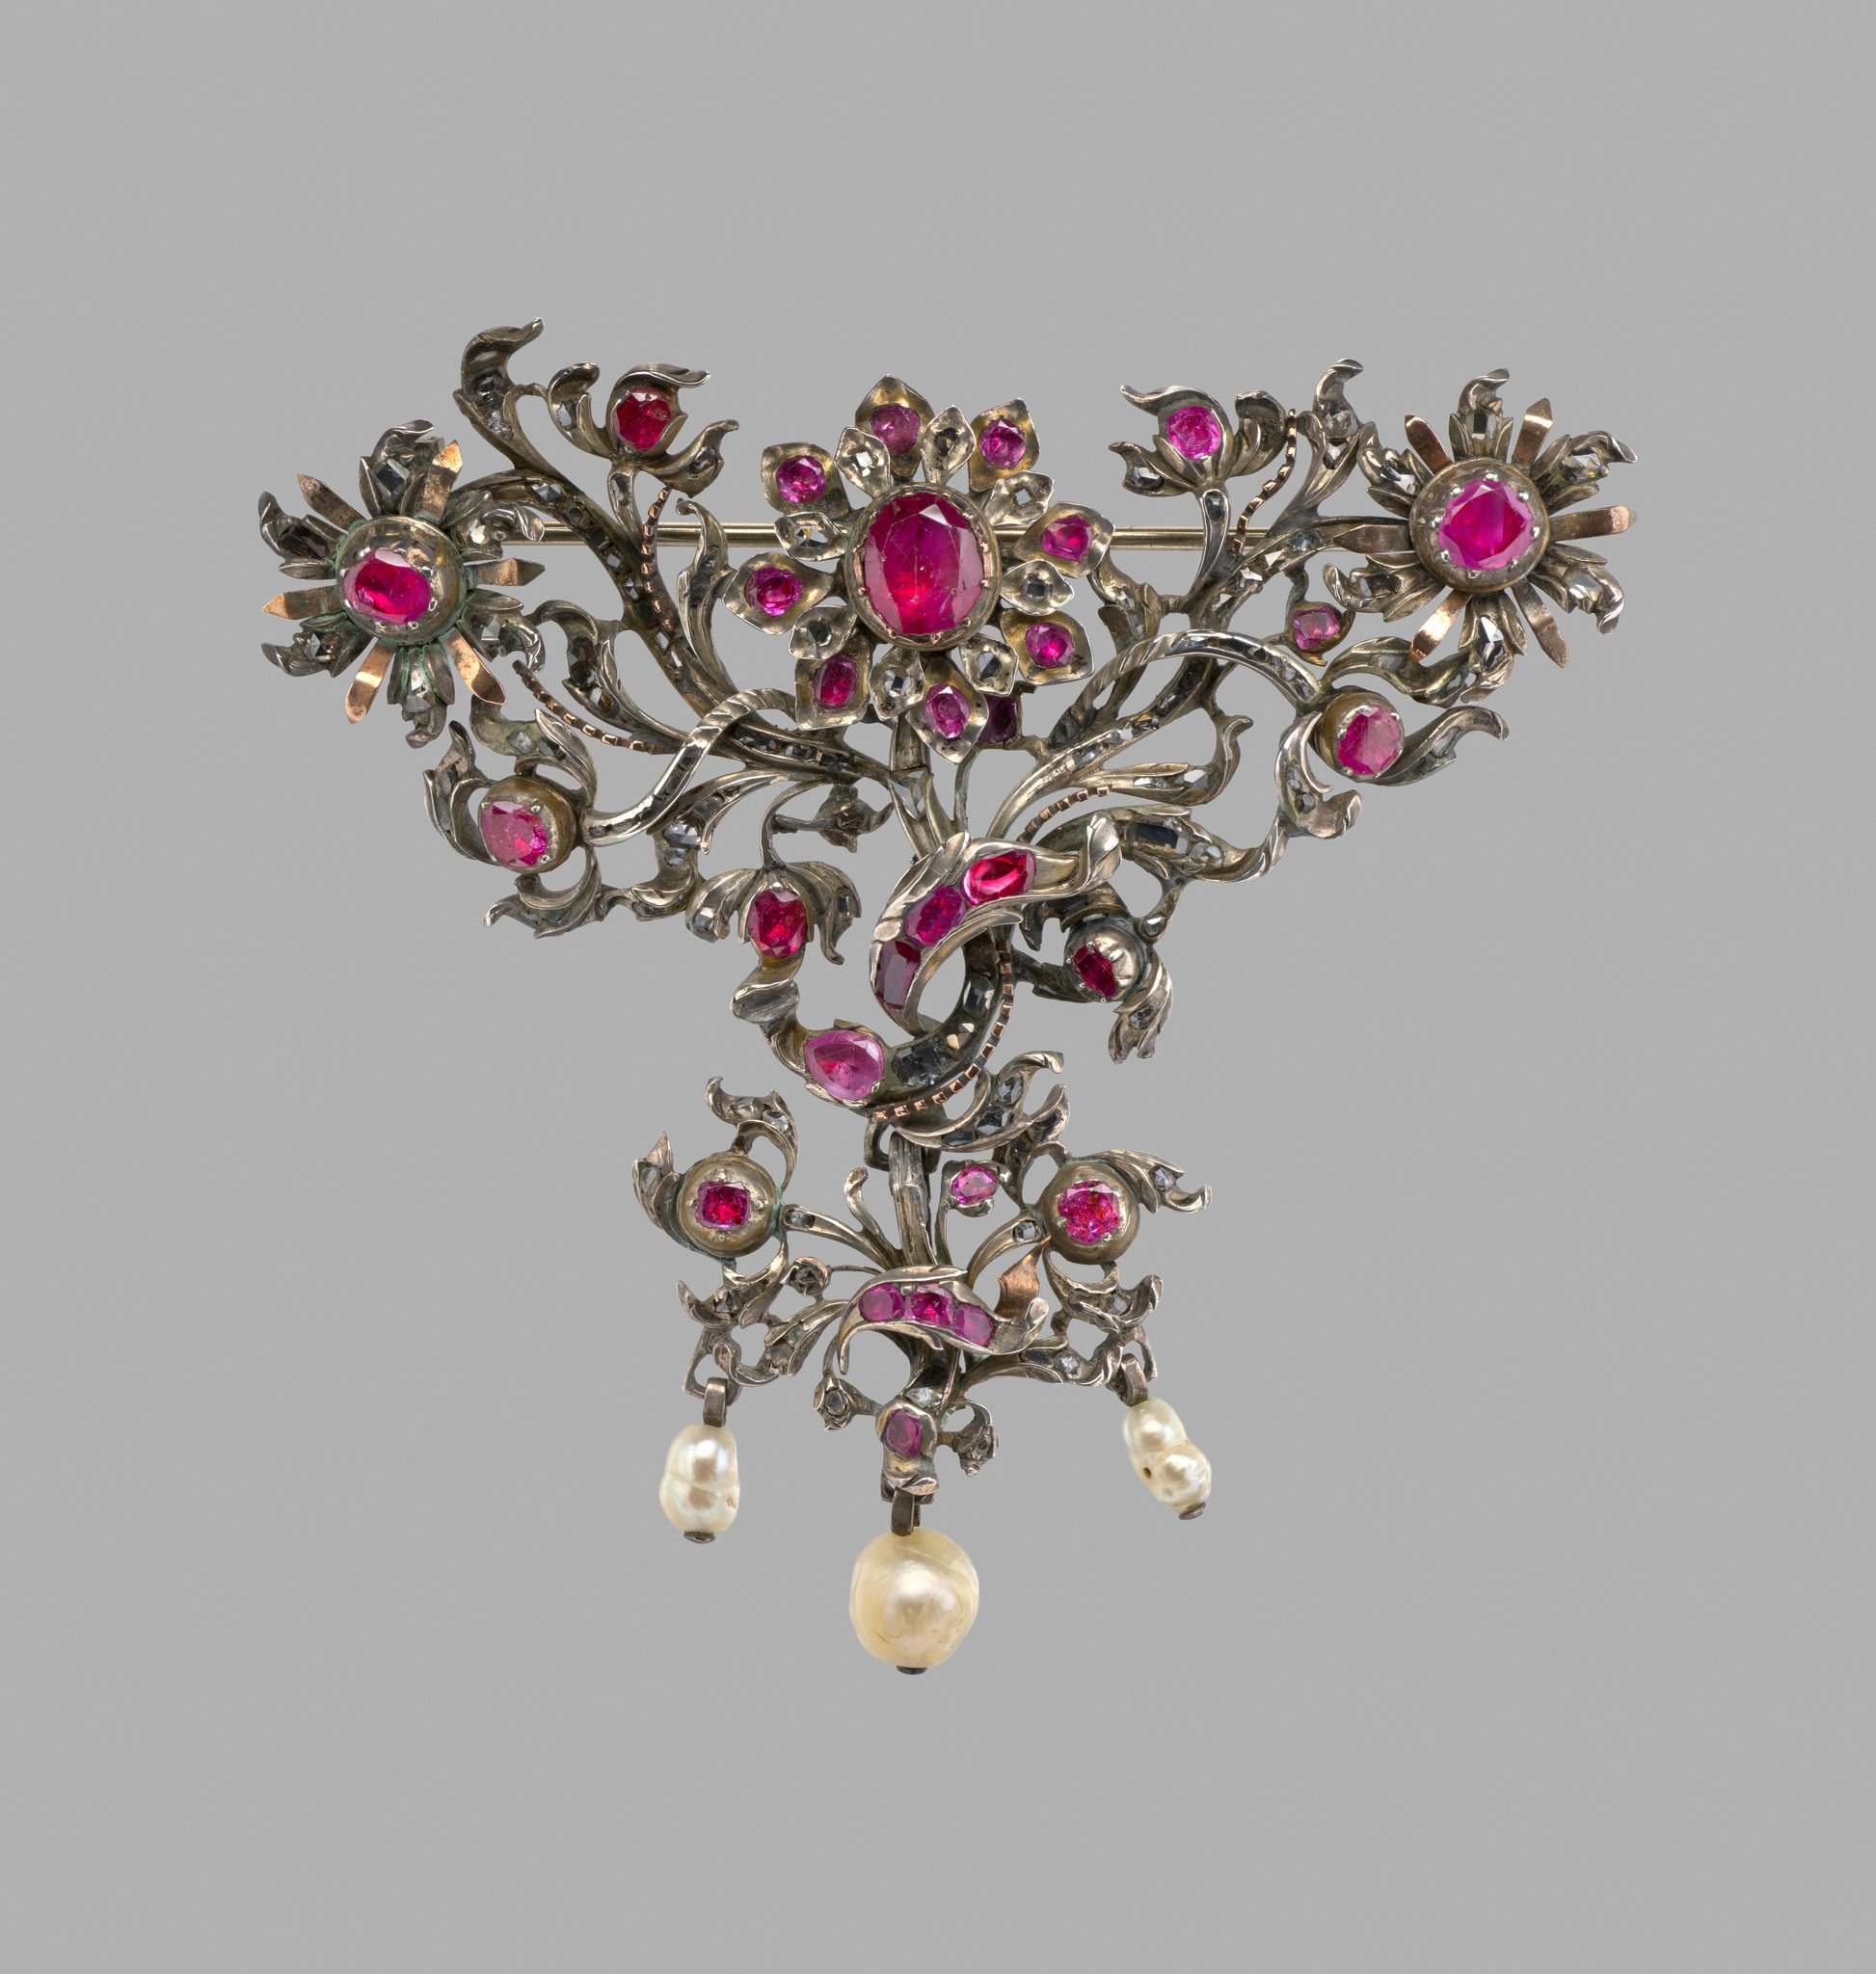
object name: corsage ornament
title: Corsage ornament (part of a set)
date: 1701-1800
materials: pearl, silver, silver gilt